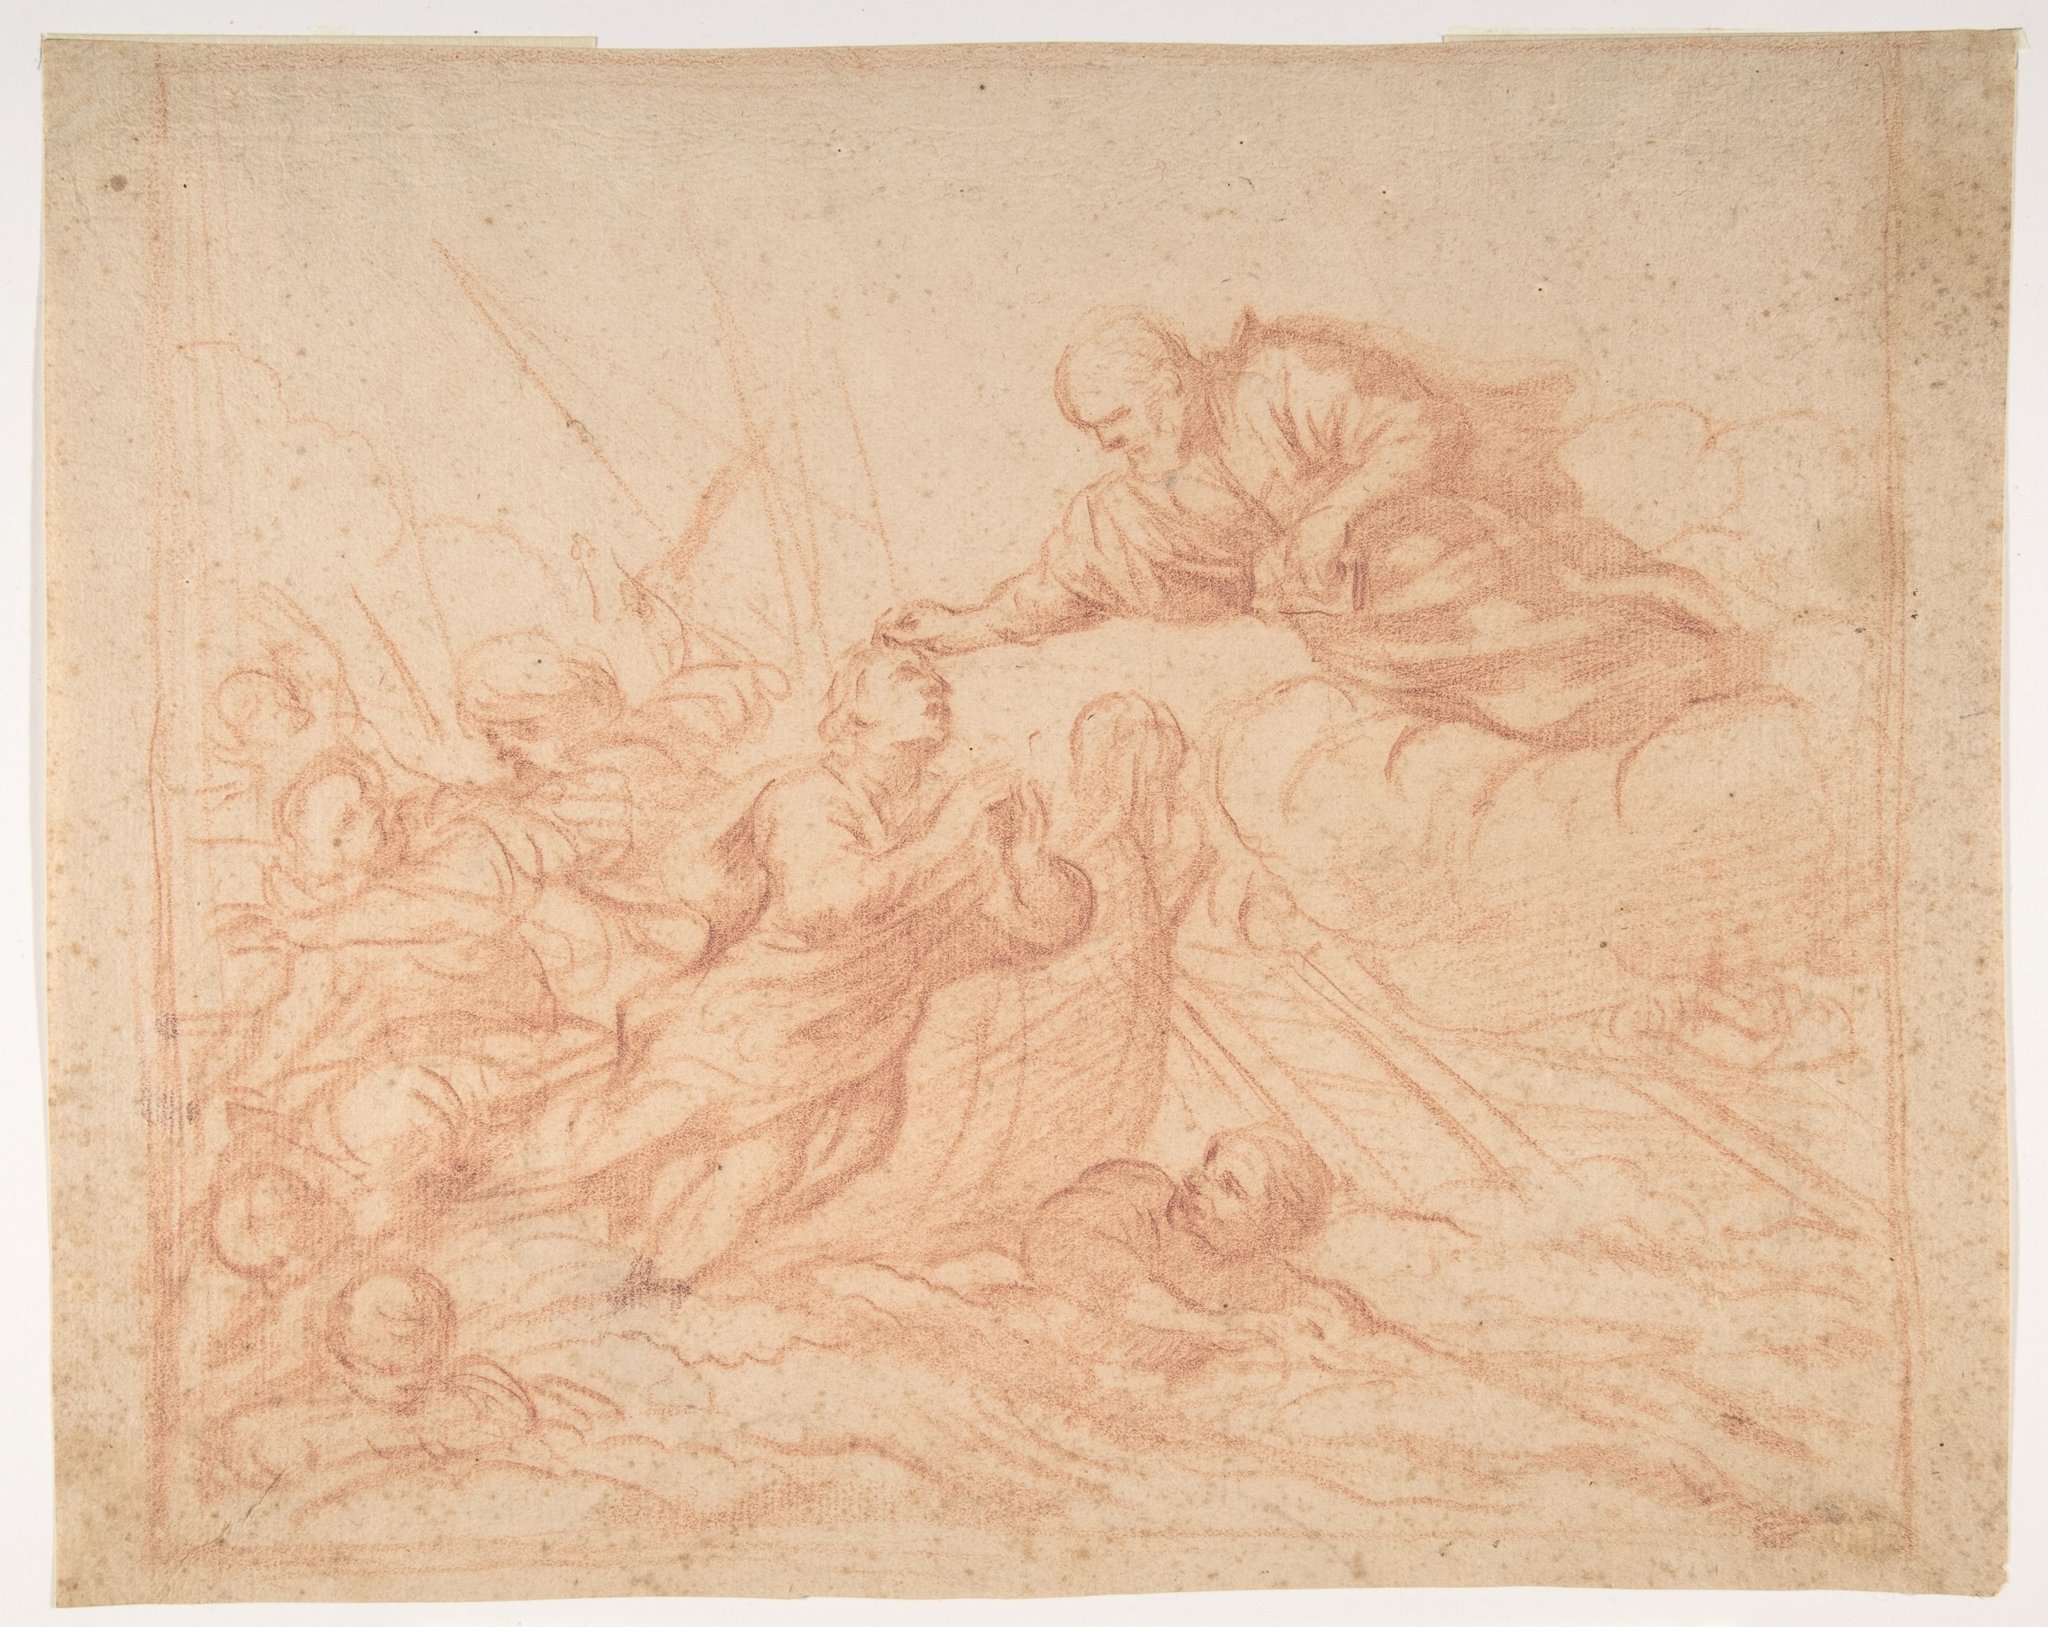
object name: drawing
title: Christ Stilling the Tempest ?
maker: paolo de matteis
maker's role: artist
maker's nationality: italian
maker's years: 1662-1728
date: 1662-1728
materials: chalk, paper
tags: men,christ